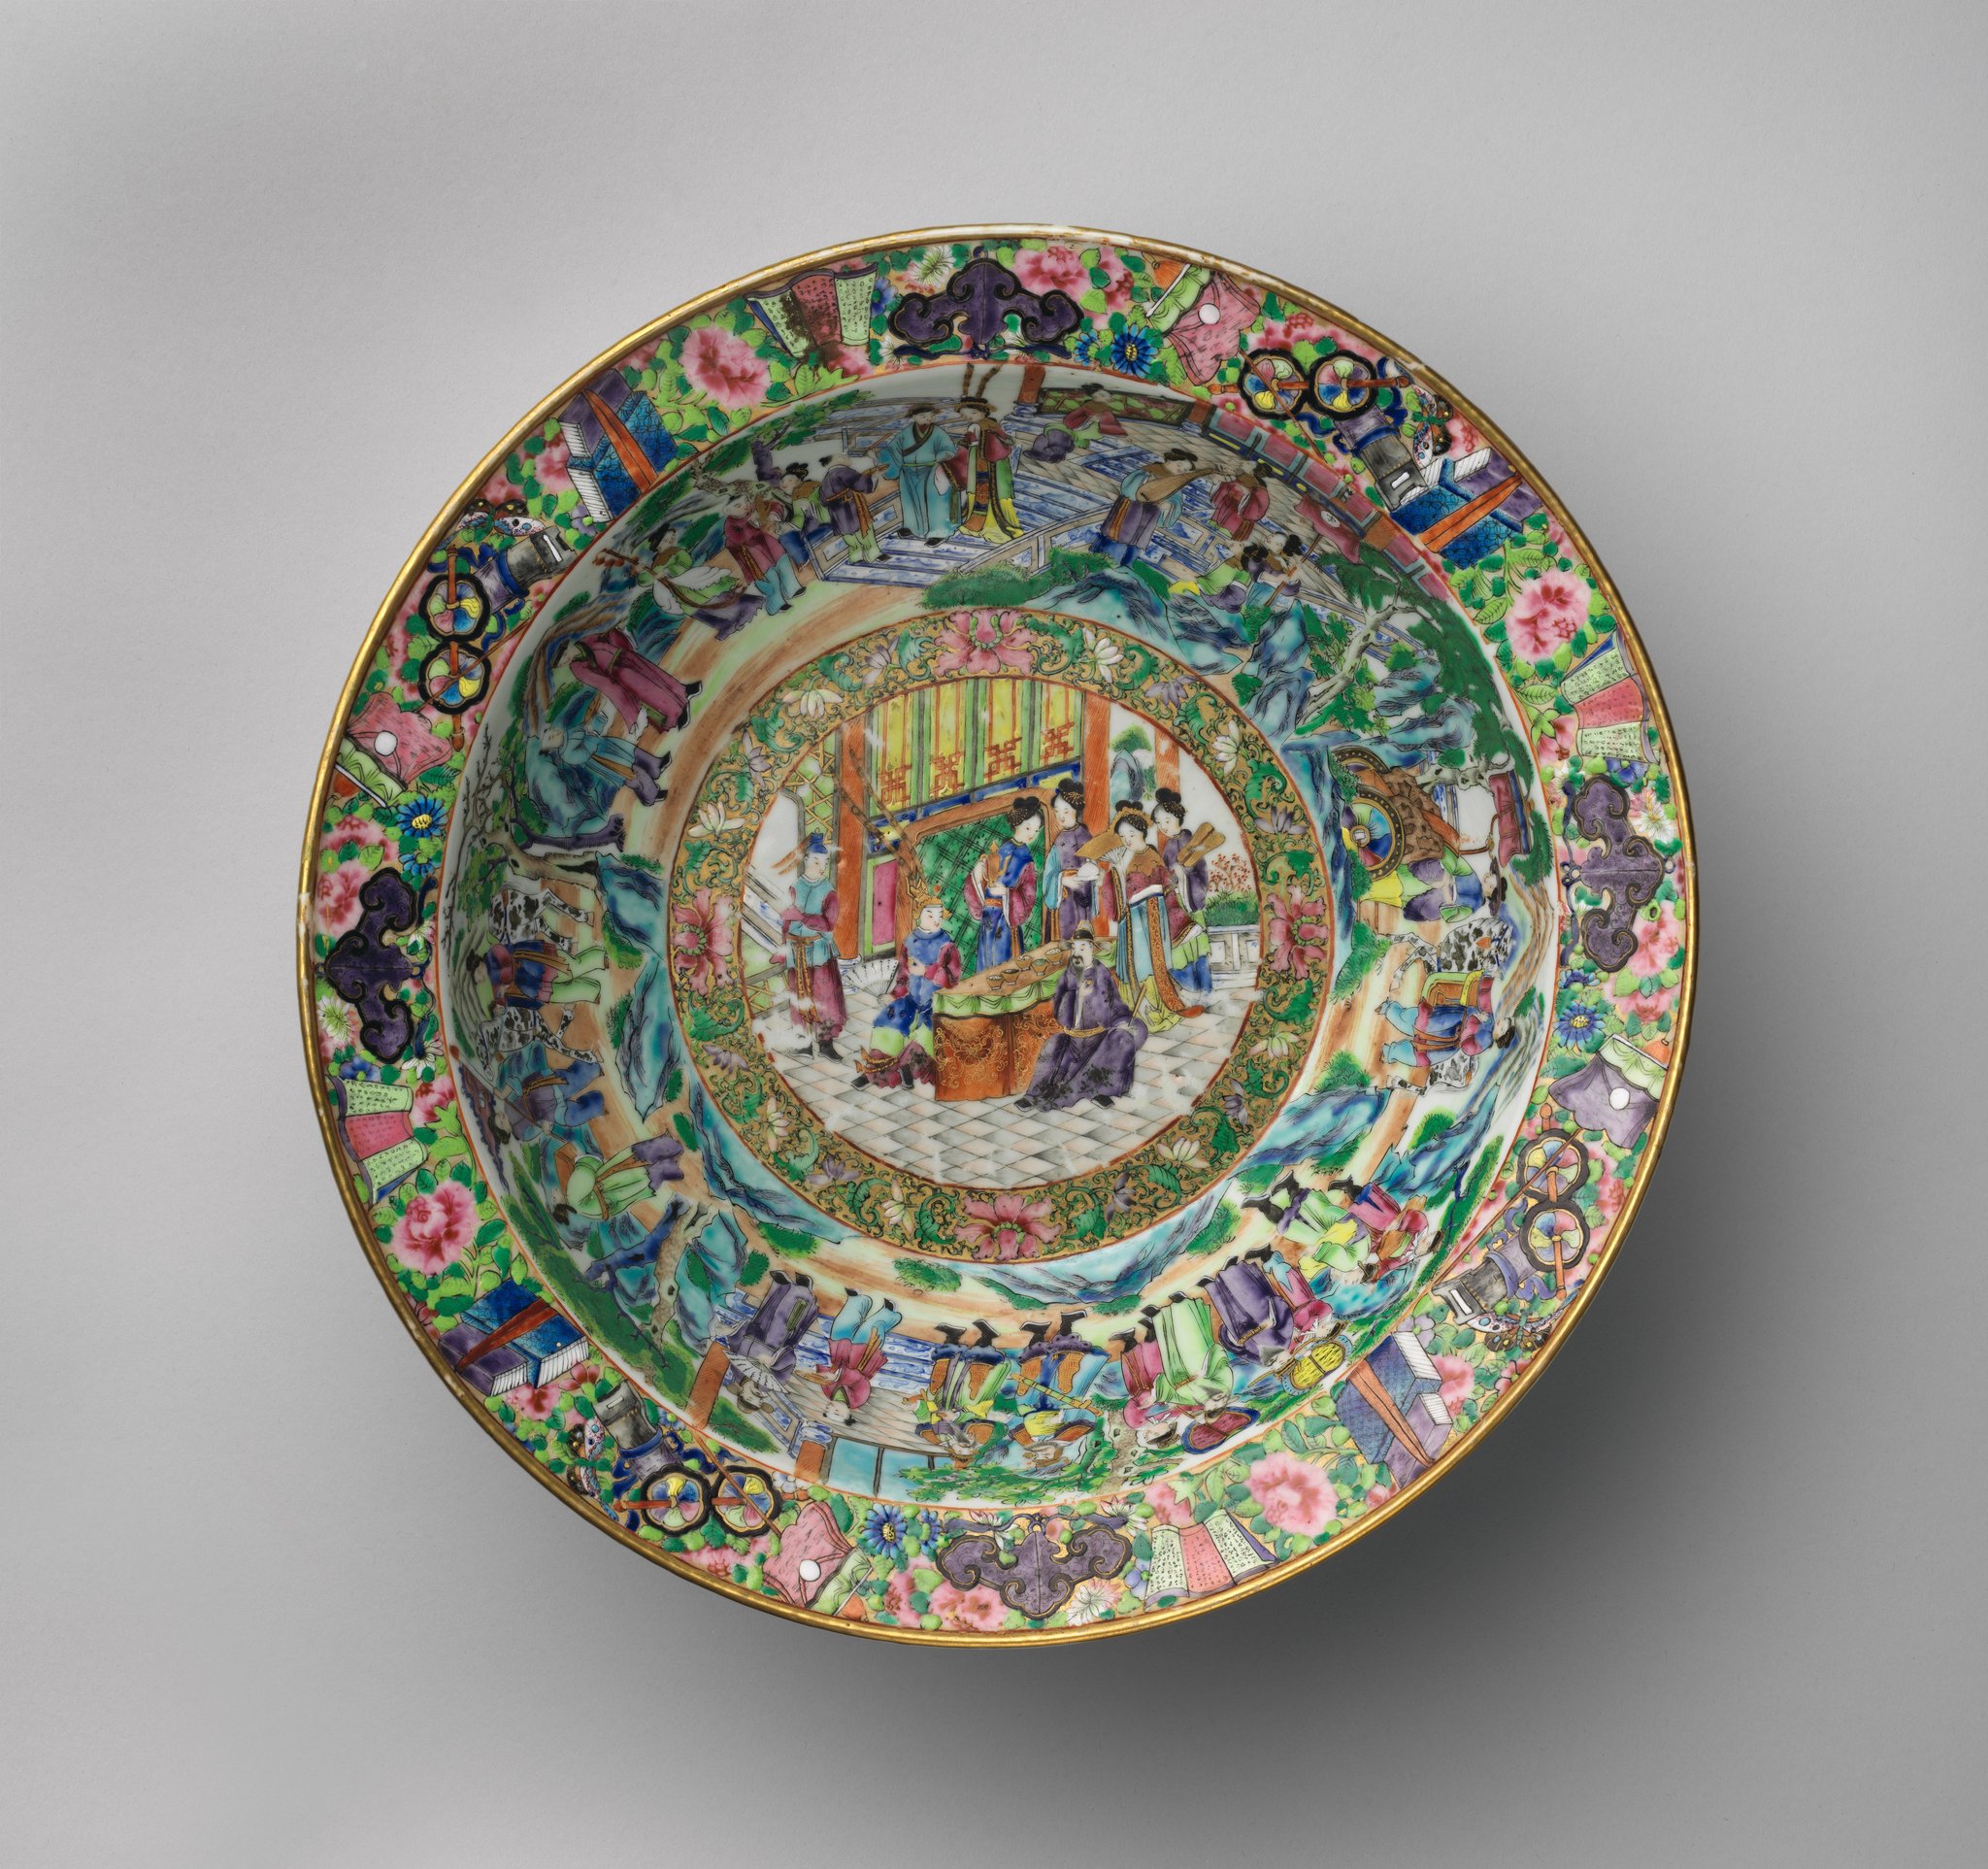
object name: basin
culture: chinese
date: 1825-1845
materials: porcelain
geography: china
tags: men,women